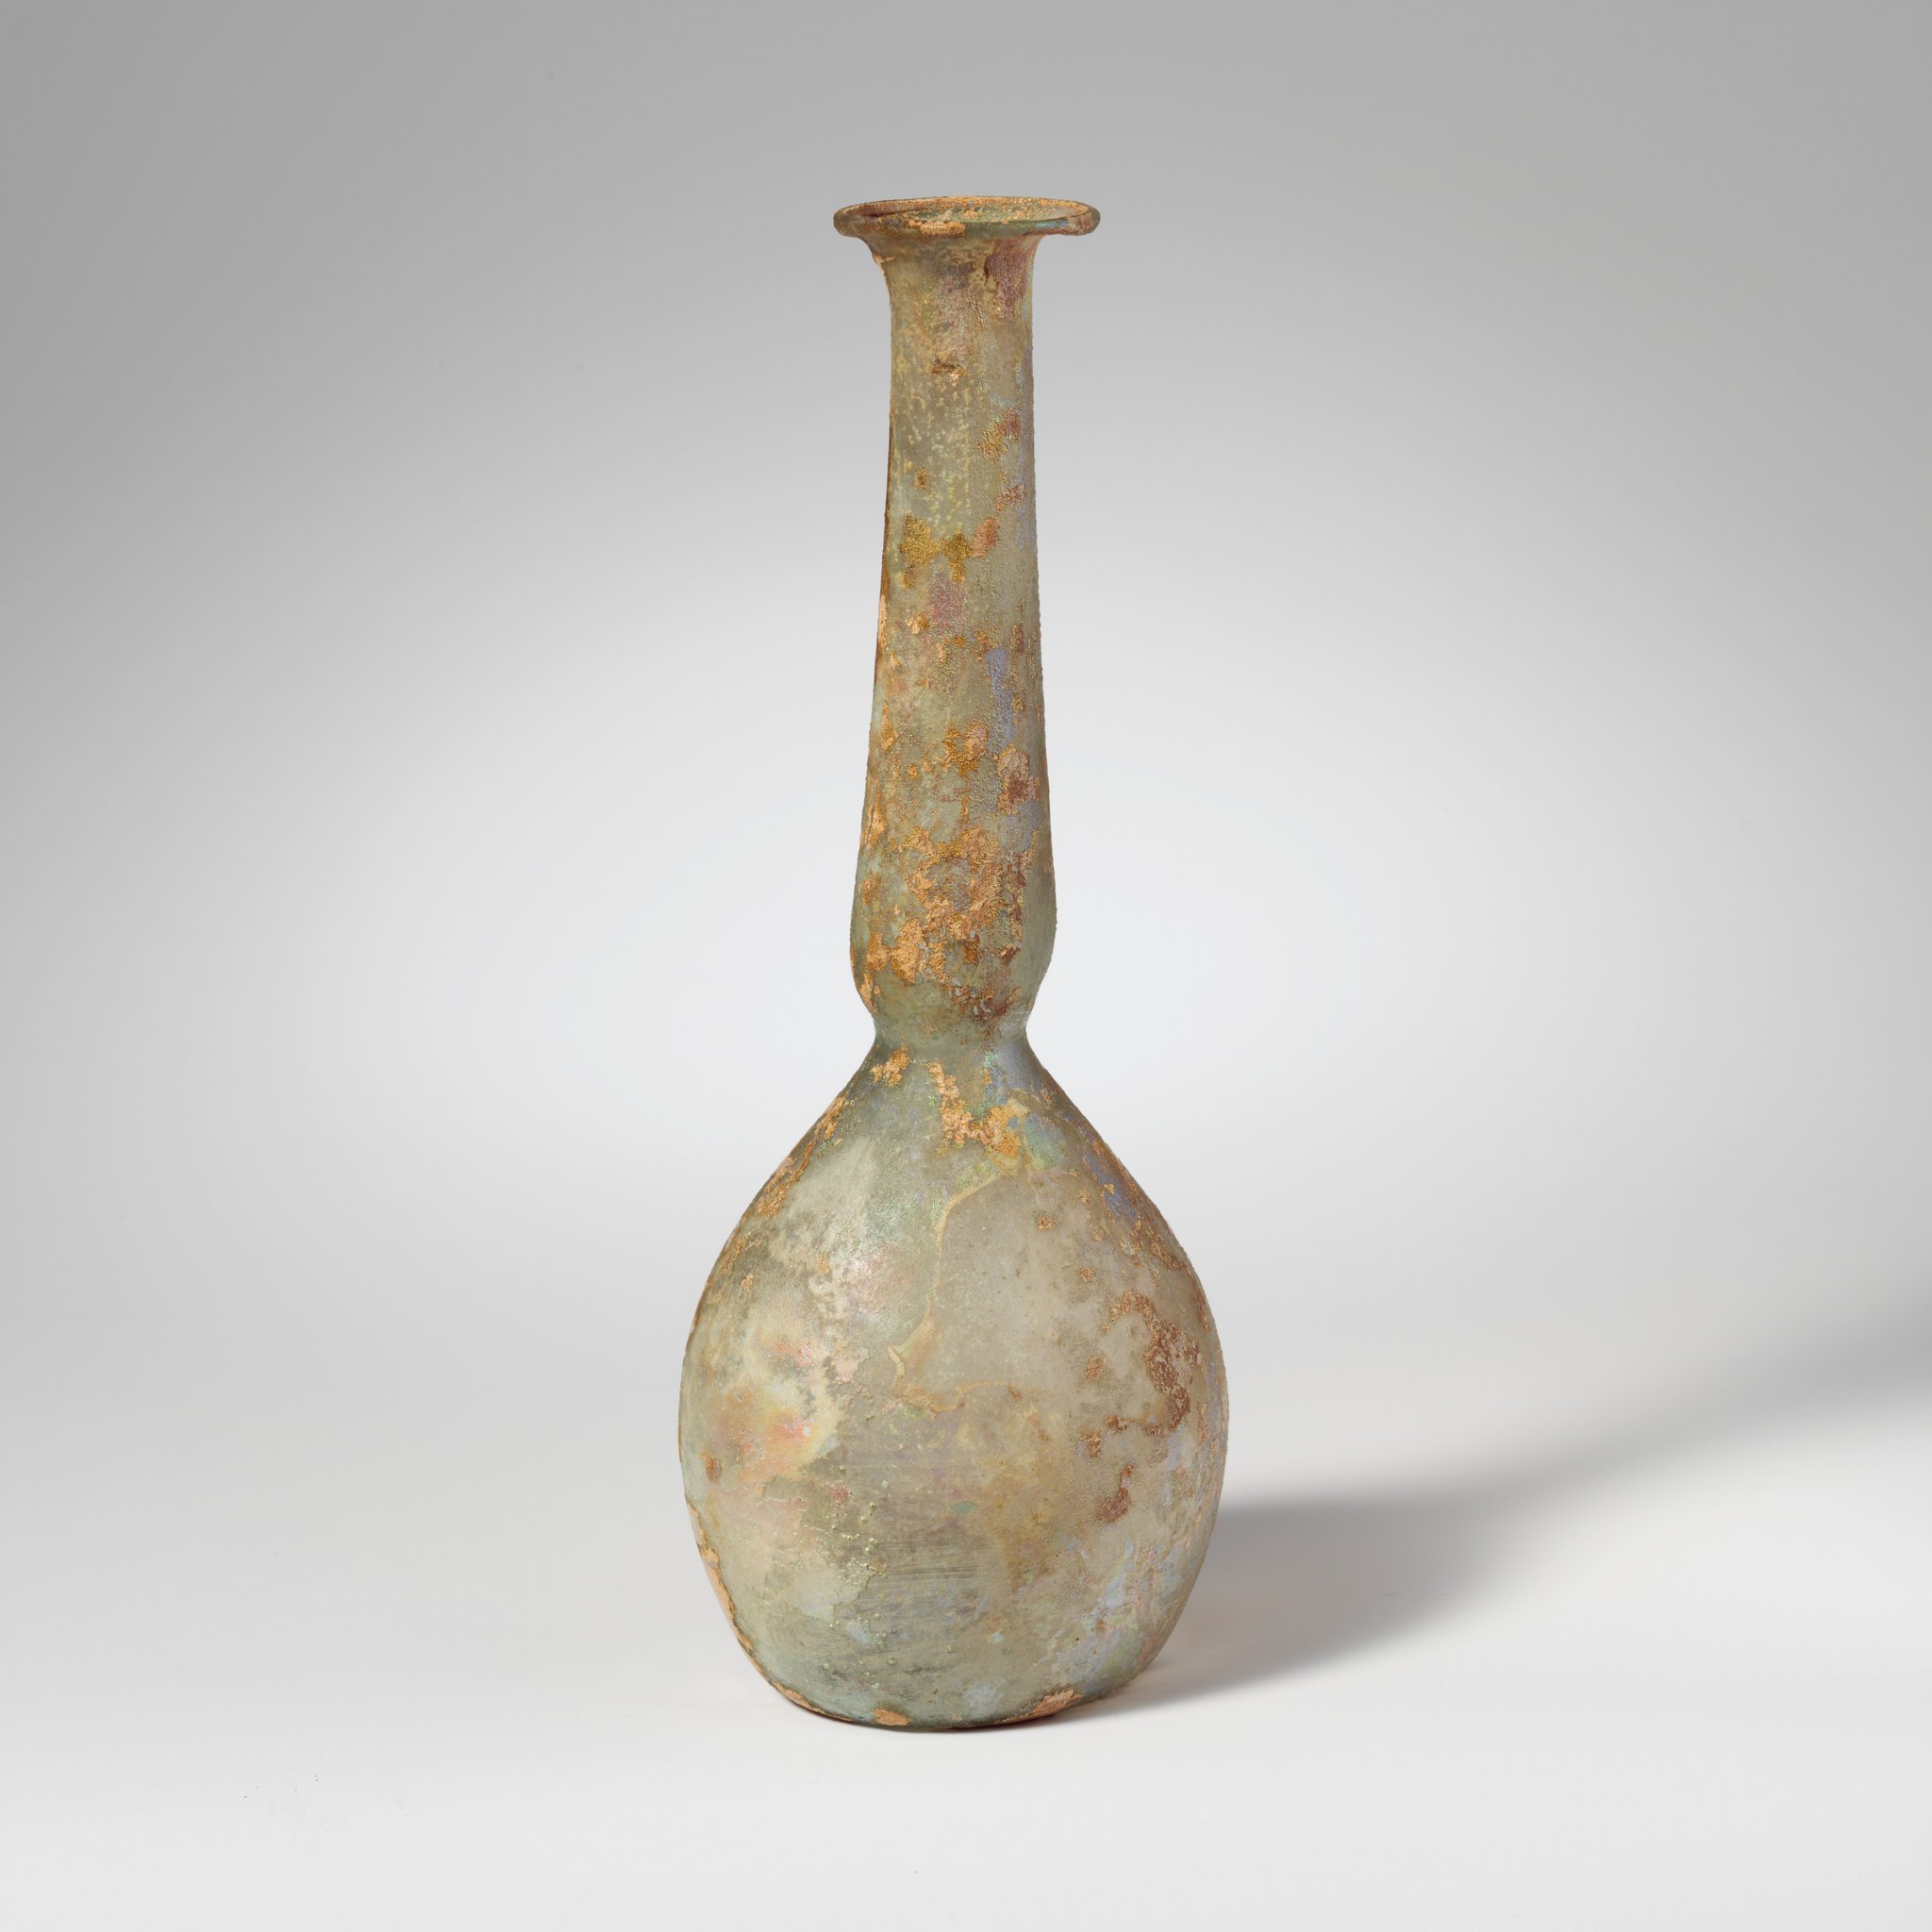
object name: perfume bottle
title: Glass perfume bottle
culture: roman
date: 101-300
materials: glass